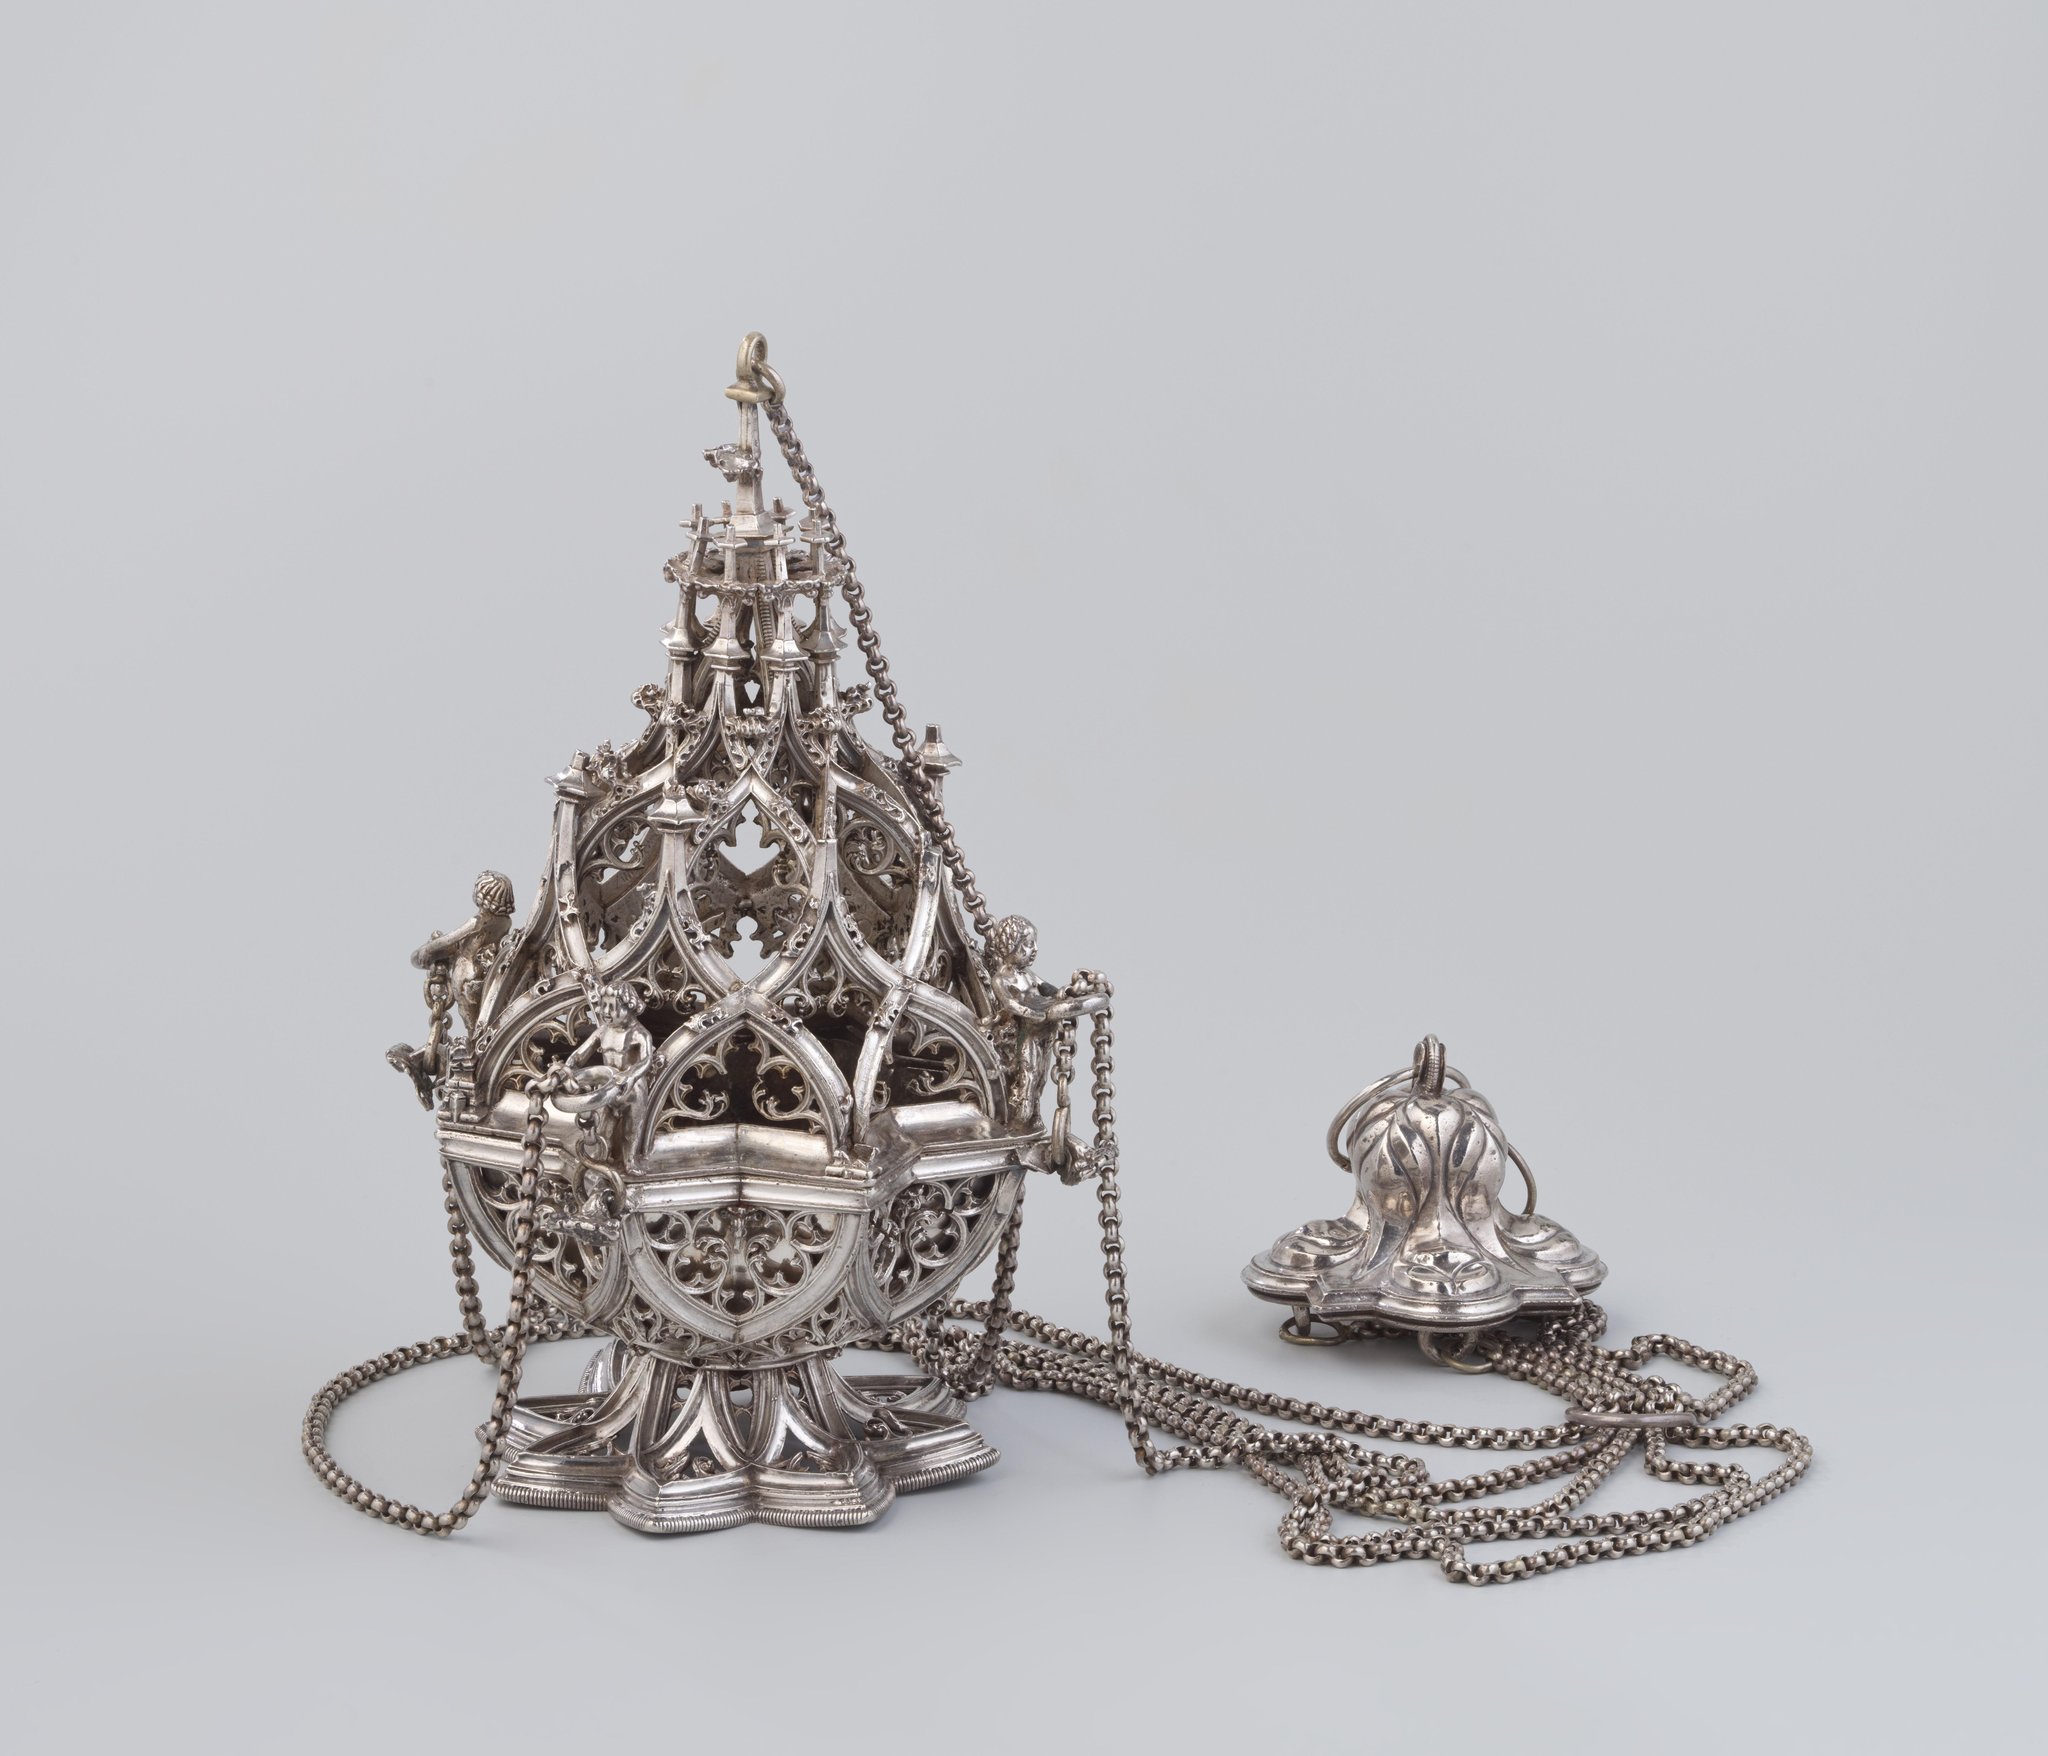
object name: censer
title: Wierookvat met kettingen en zon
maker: Anonymous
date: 1480-1500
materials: silver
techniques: assembly, casting, metalworking, embroidery, riveted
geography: netherlands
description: Het achtkantige, opengewerkte wierookvat heeft een gewelfde voet, een bol gefacetteerd lichaam, waarin een gesloten vergulde bak is geschroefd, en een hoog gewelfd deksel. Uit profielen samengestelde ribben vormen de spitsbogen op de voet en verdelen deze in symmetrisch gebogen velden van verschillend formaat. Het patroon wordt voortgezet op het lichaam. De bovenzijde wordt afgesloten door een brede, geprofileerde rand. Op vier van de acht punten wordt deze door een gebogen kruisbloem gemarkeerd. Boven een brede holle lijst wordt het patroon van de elkaar doorsnijdende ribben op het deksel voortgezet in drie rijen gedrukte spitsbogen boven elkaar. Onder worden de snijpunten afwisselend benadrukt door samengestelde pinakels op voet en kindertjes met ringen. De spitsbogen worden bekroond door pinakels van verschillend formaat. Alleen de bovenste twee rijen zijn min of meer compleet, en geven aan dat de pinakels boven een achtkantige voet een hoge stam bezaten die door een kruisbloem wordt gemarkeerd. De kleinste velden zijn op de voet gevuld met boven elkaar geplaatste cirkels, de grotere afwisselend met driepassen en krullend blad; op die van het lichaam worden beide laatste patronen gecombineerd en de velden op het deksel zijn gedeeltelijk met dezelfde patronen gevuld. De ribben van de laatste zijn plaatselijk met krullend blad versierd. Door middel van vijf kettingen wordt het geheel verbonden met een achtkantig gewelfde zon, waarvan de gewelfde bovenzijde met een kruisbloem is versierd. Op de onderzijde zijn vier gladde ringen gemonteerd, op de bovenzijde één ring die met een koordband is versierd. Koordbanden komen ook voor op het bovenste segment van het deksel en op de buitenrand van de voet.